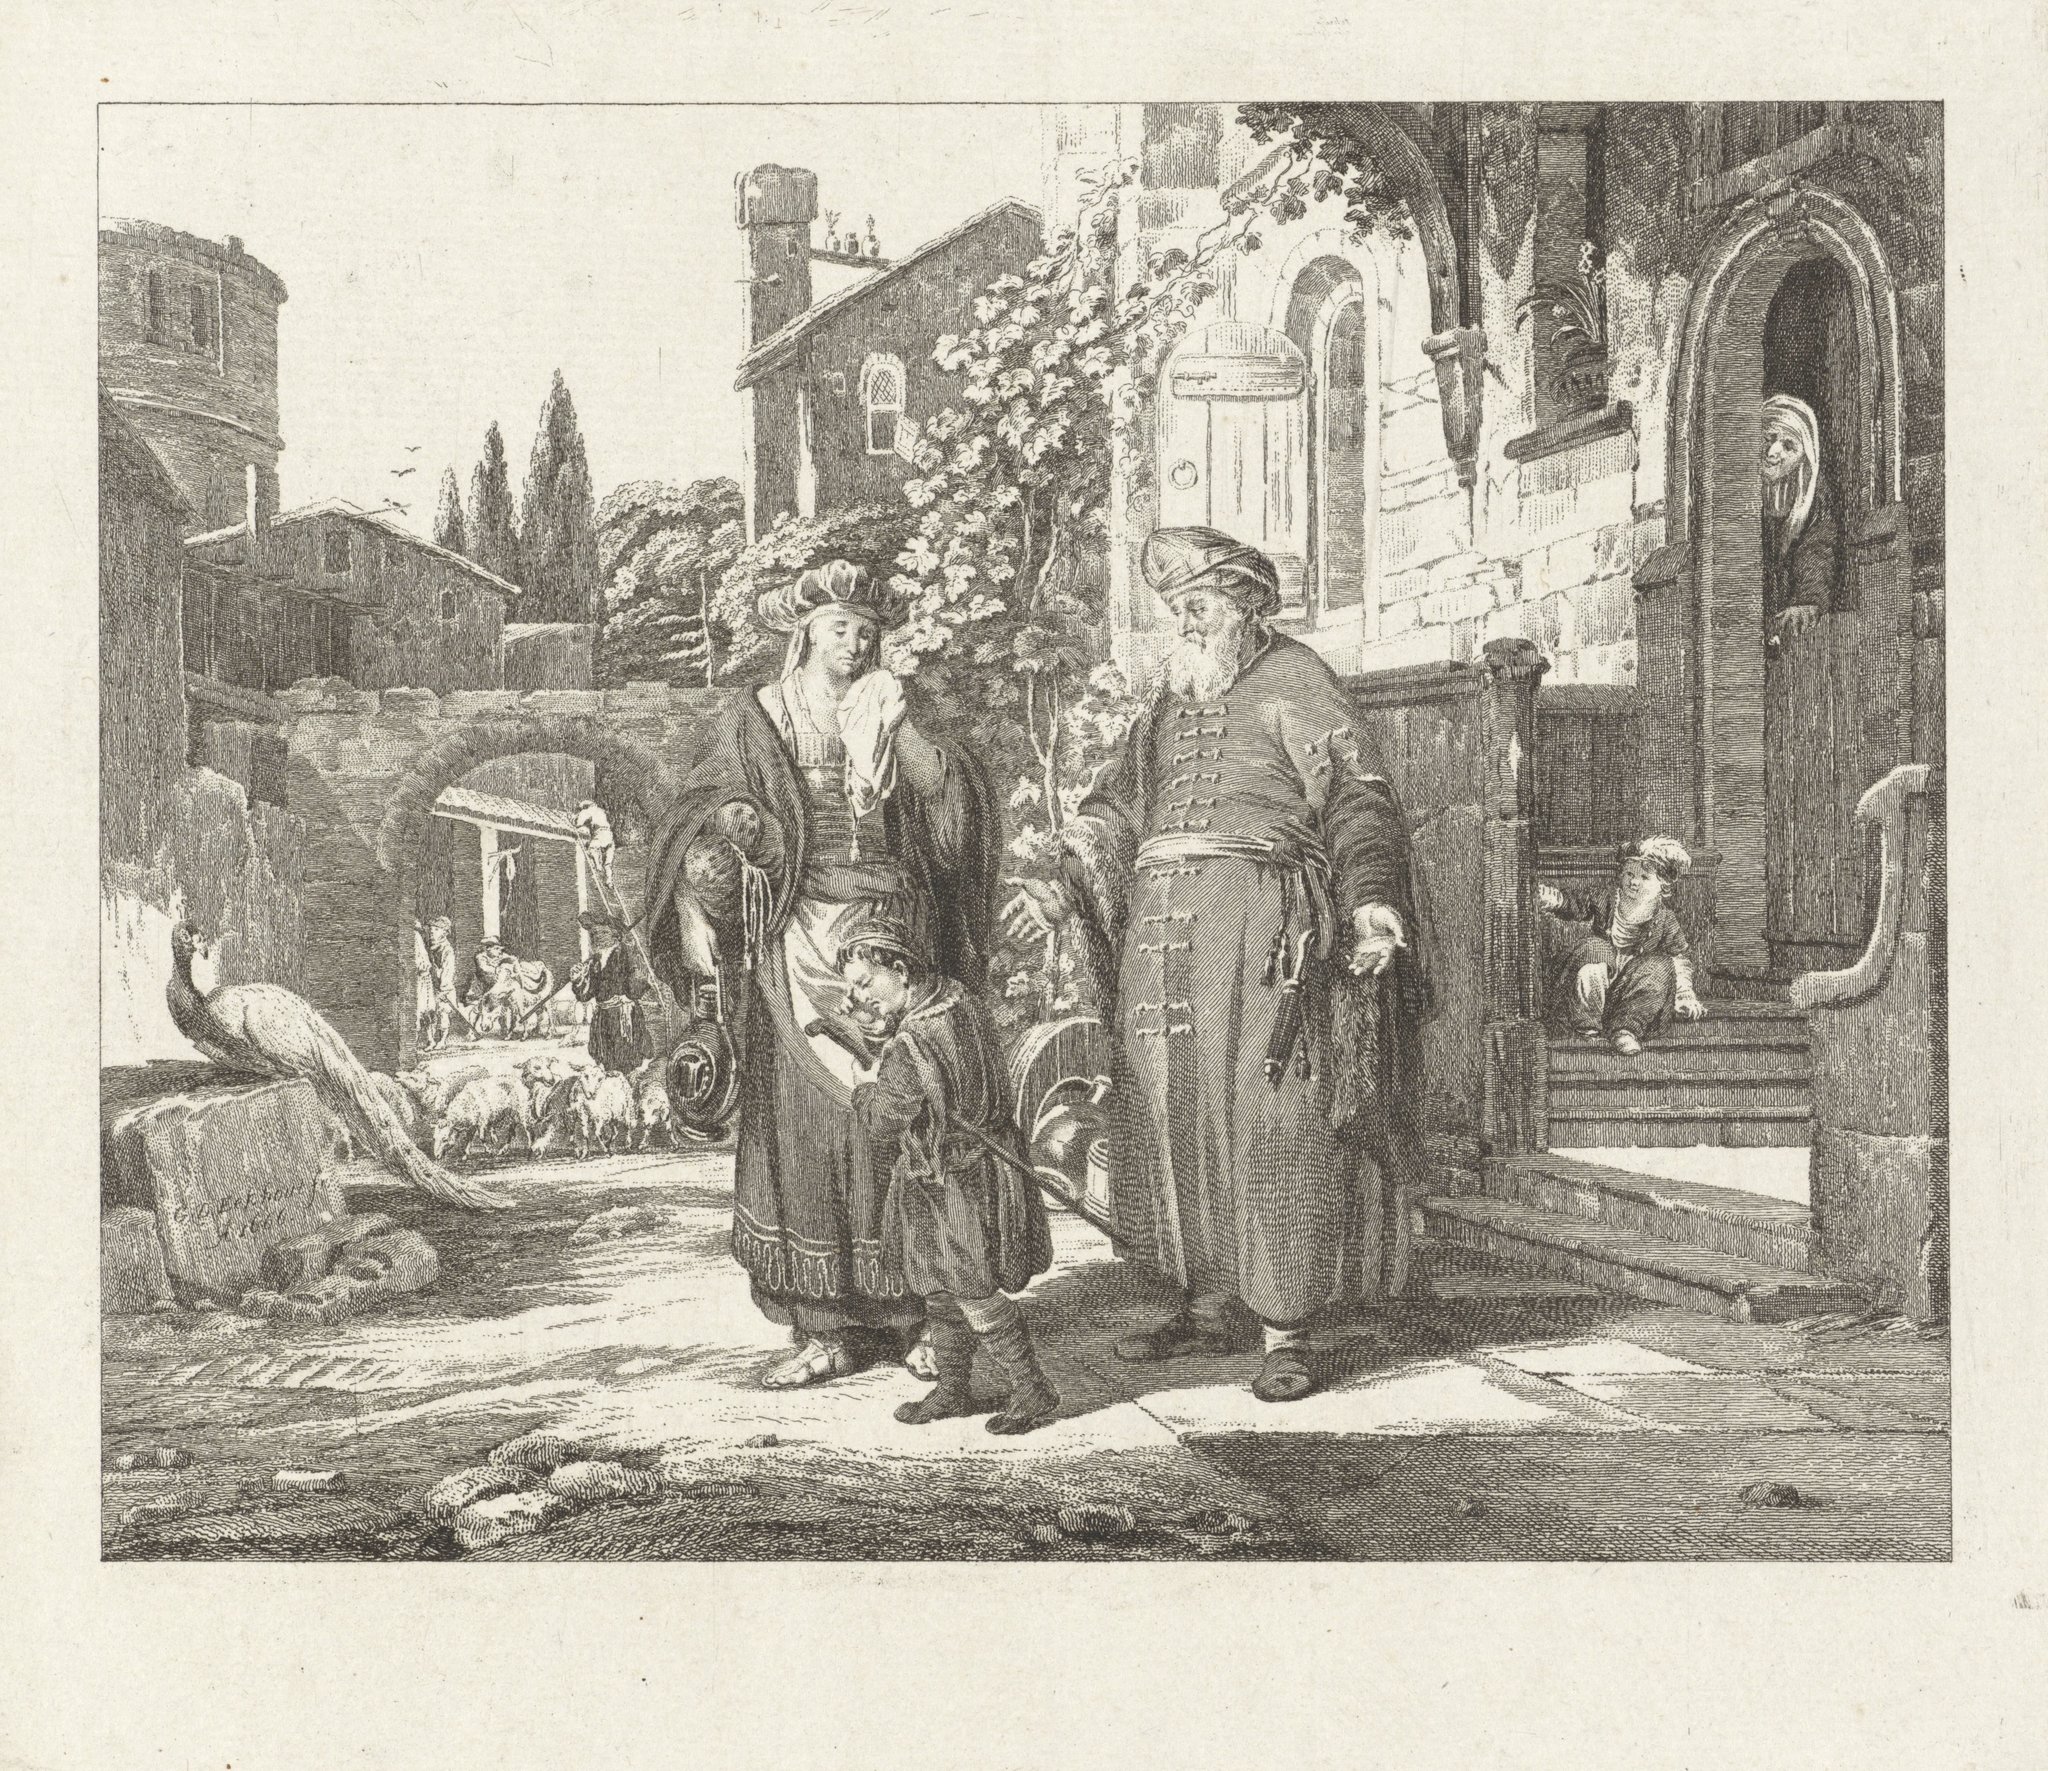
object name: print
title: Hagar en Ismaël door Abraham verstoten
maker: reinier vinkeles (i)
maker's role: draughtsman, print maker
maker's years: 1741-1816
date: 1751-1816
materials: paper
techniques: etching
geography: amsterdam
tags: the banishment of hagar and ishmael (genesis 21:9-21)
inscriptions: collector's mark: Lugt 2228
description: Abraham staat voor zijn huis en stuurt Hagar en Ismaël weg. Ismaël heeft een wandelstok, Hagar droogt haar tranen met een zakdoek. Achter Abraham staat Sara in de deuropening.